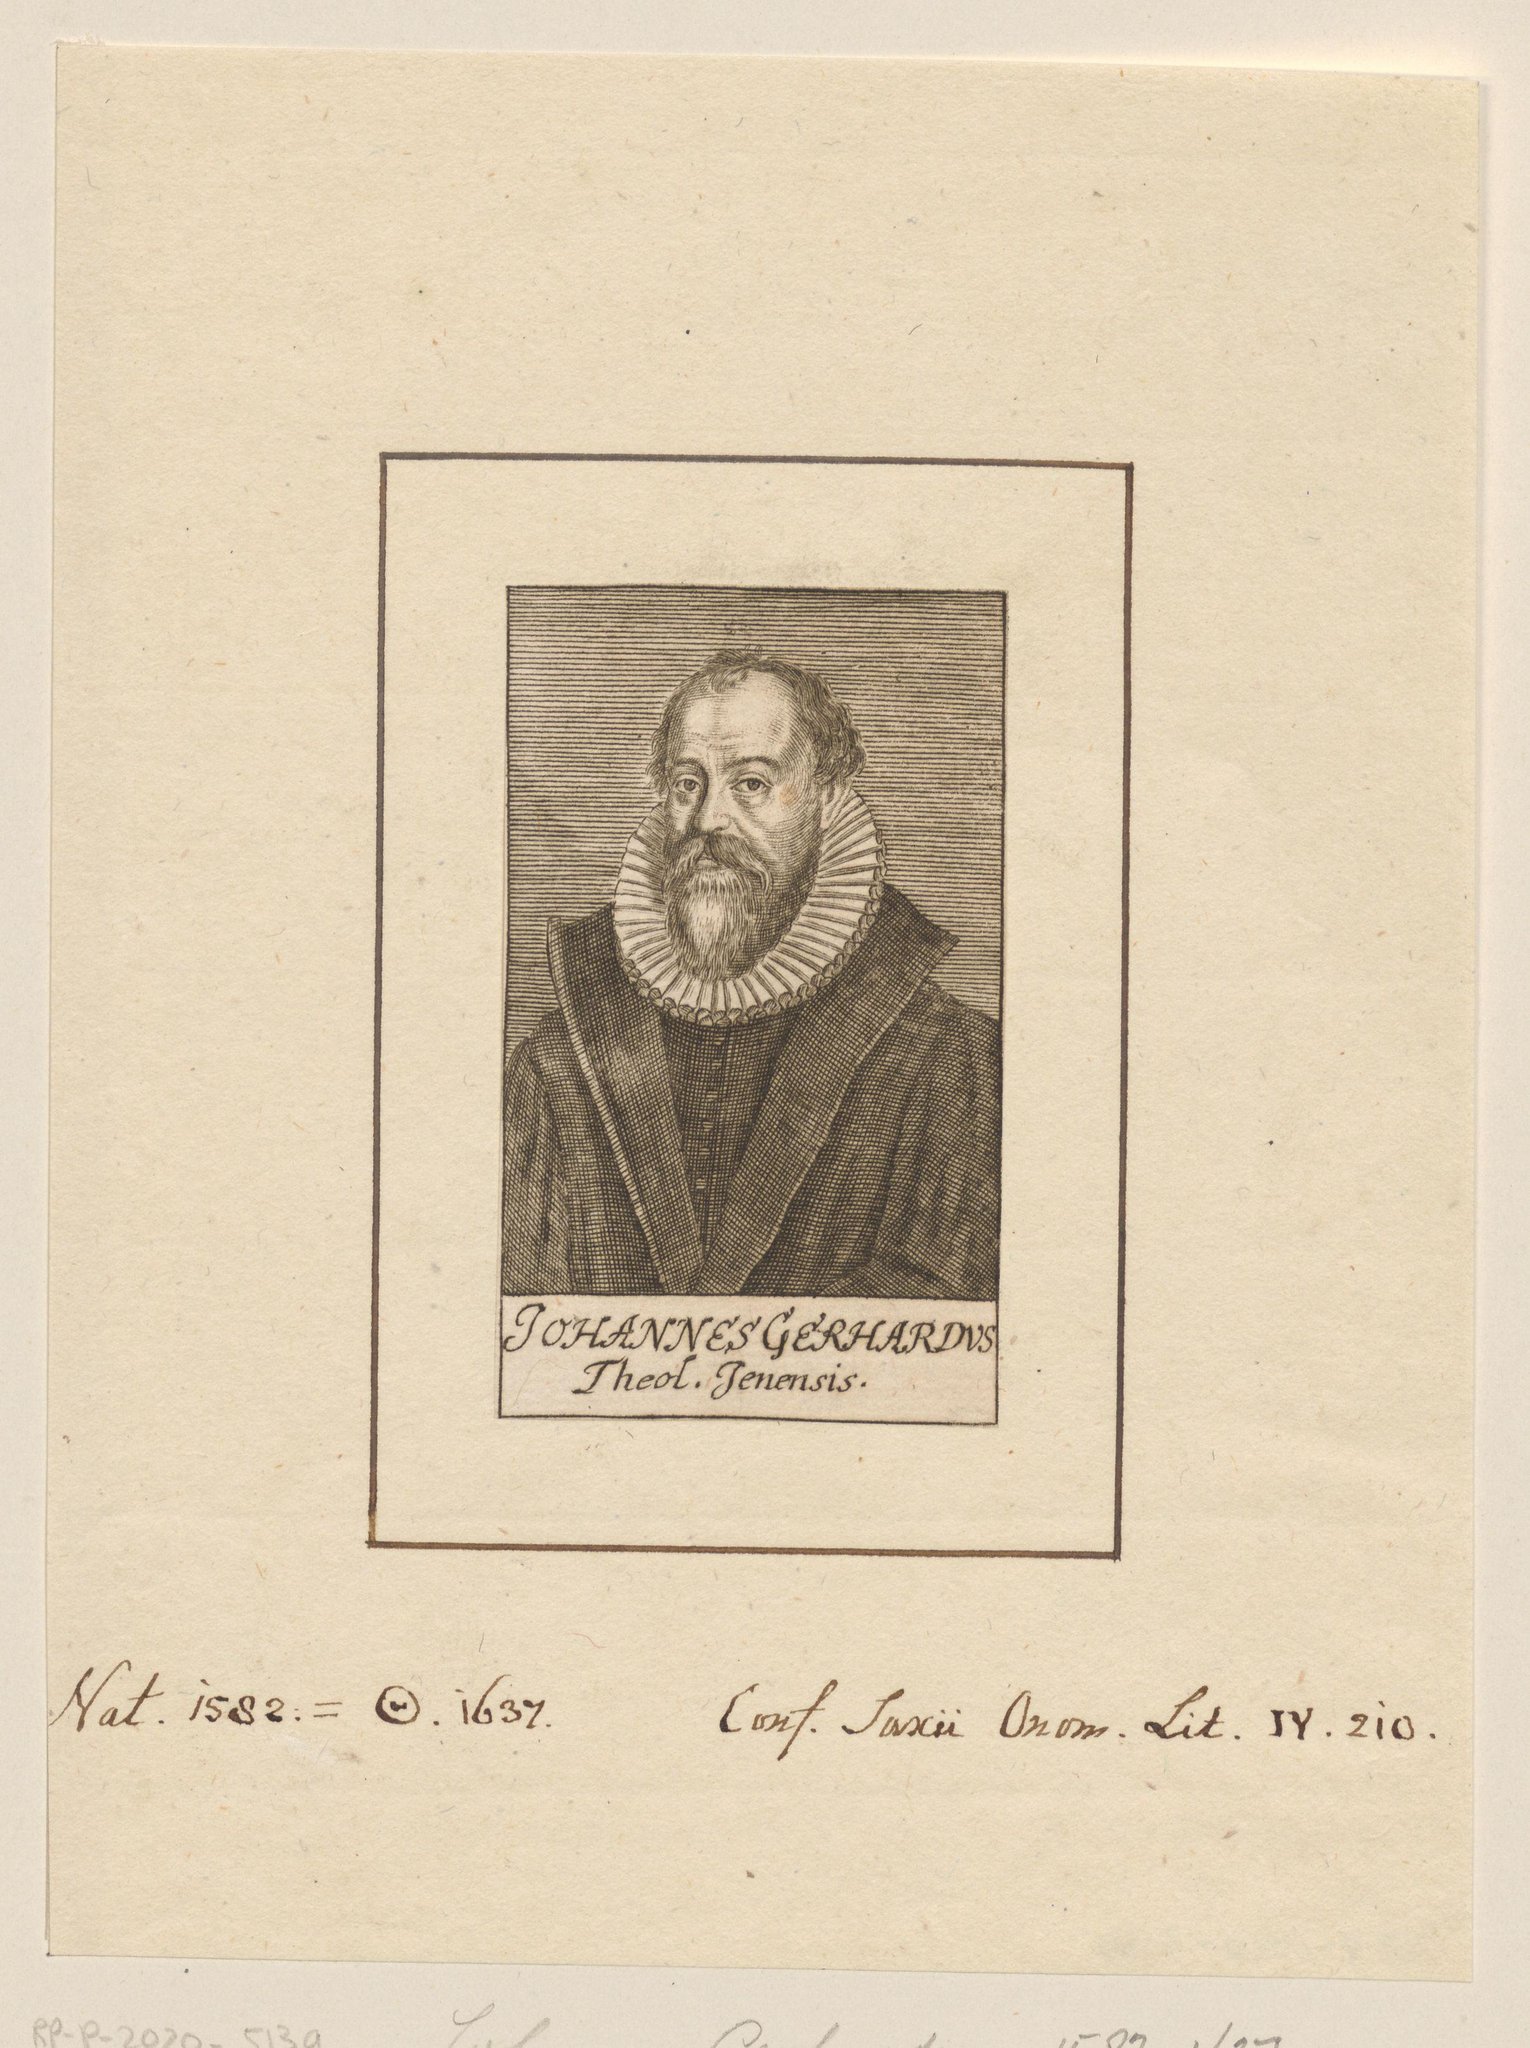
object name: book illustration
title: Portret van Johann Gerhard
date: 1688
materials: paper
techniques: engraving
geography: nuremberg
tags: theologian, historical persons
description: Prent uit: Freher, Paul. Theatrum virorum eruditione clarorum. Neurenberg: Johann Hoffmann, 1688, blad 23.